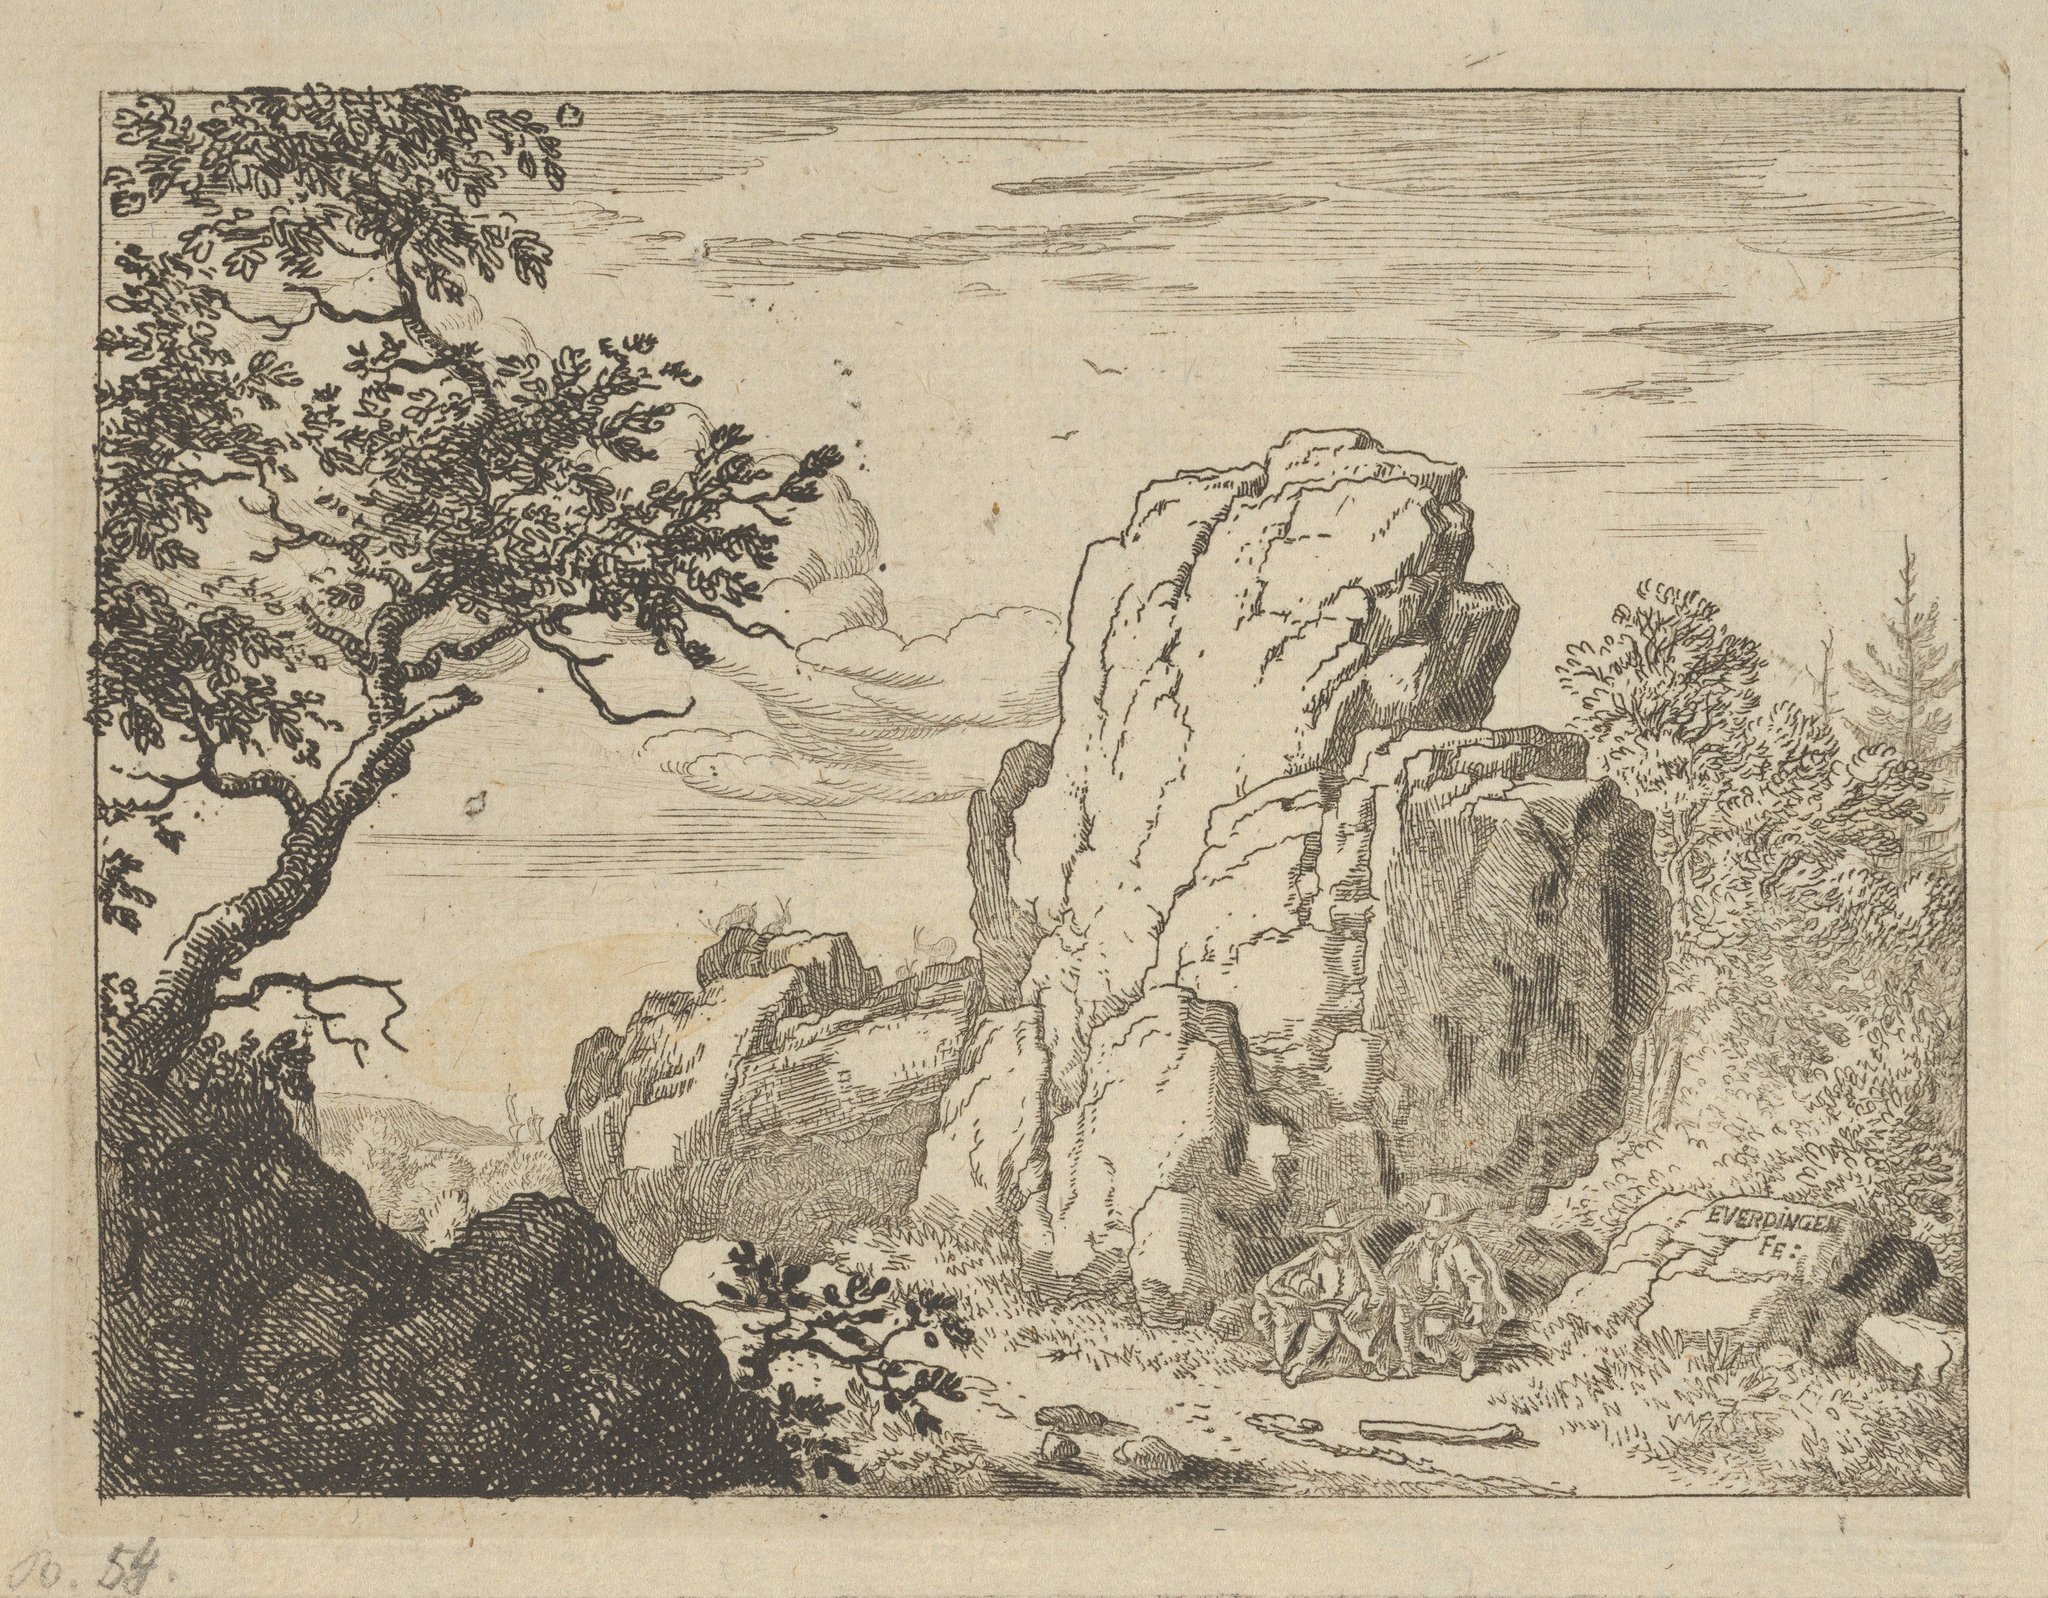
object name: print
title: Two Men Seated at the Foot of a High Rock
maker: allart van everdingen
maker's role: artist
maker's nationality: dutch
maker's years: 1621-1675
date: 1621-1675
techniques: engraving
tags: men,trees